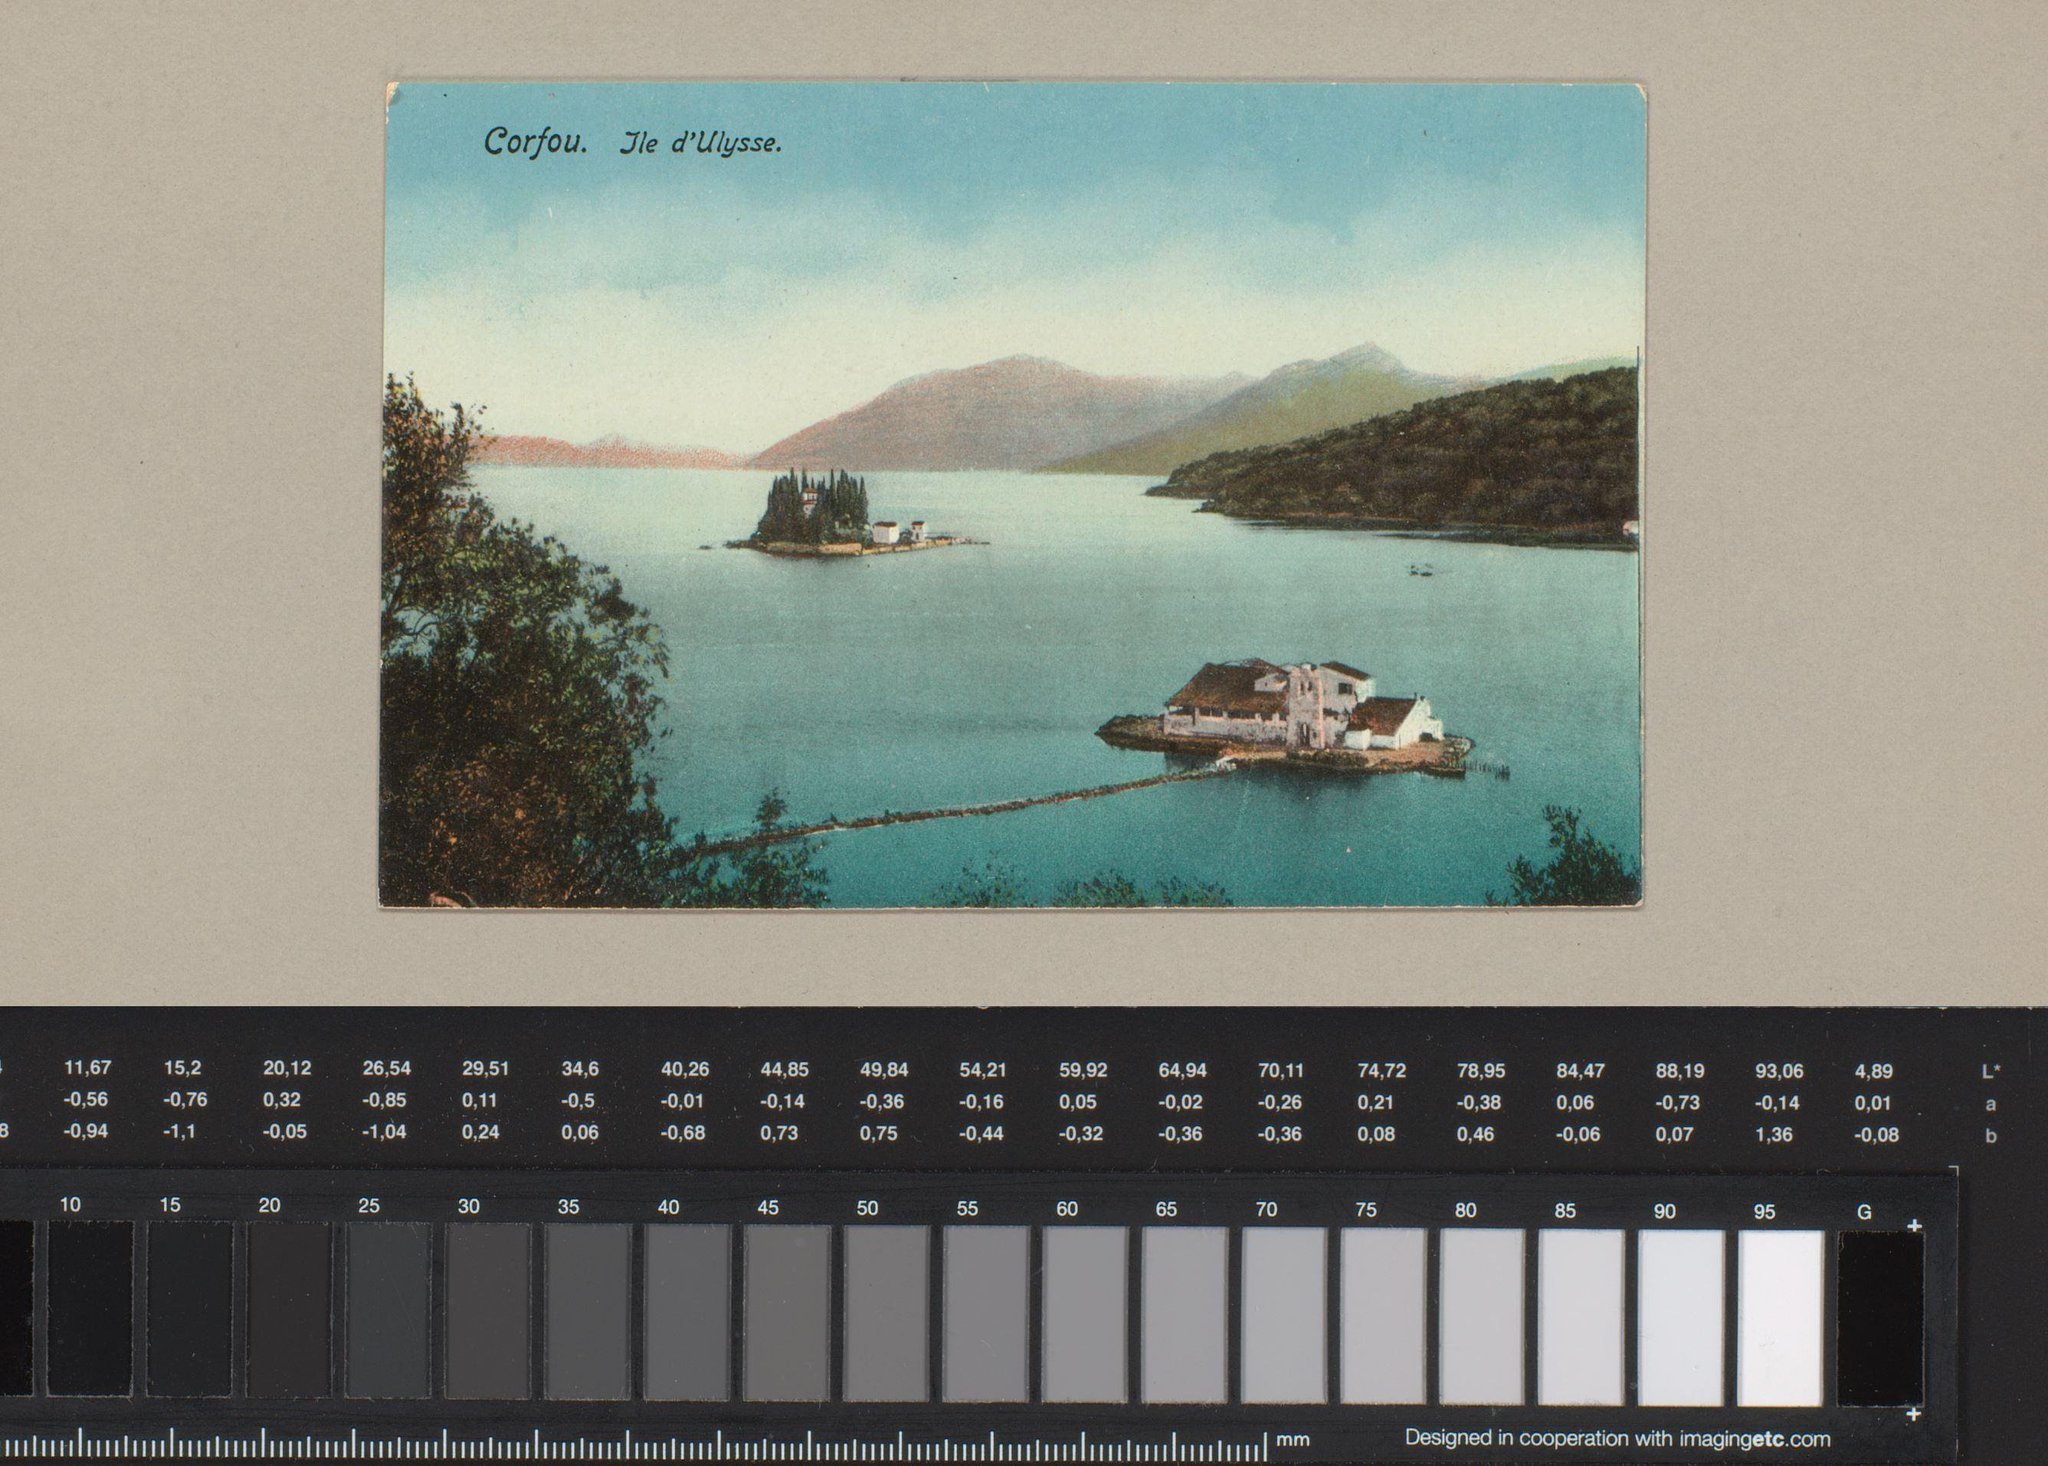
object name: photograph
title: Gezicht op Corfu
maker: Anonymous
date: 1895-1915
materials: cardboard, paper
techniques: lithograph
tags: korfoe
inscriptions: number: ‘64.’